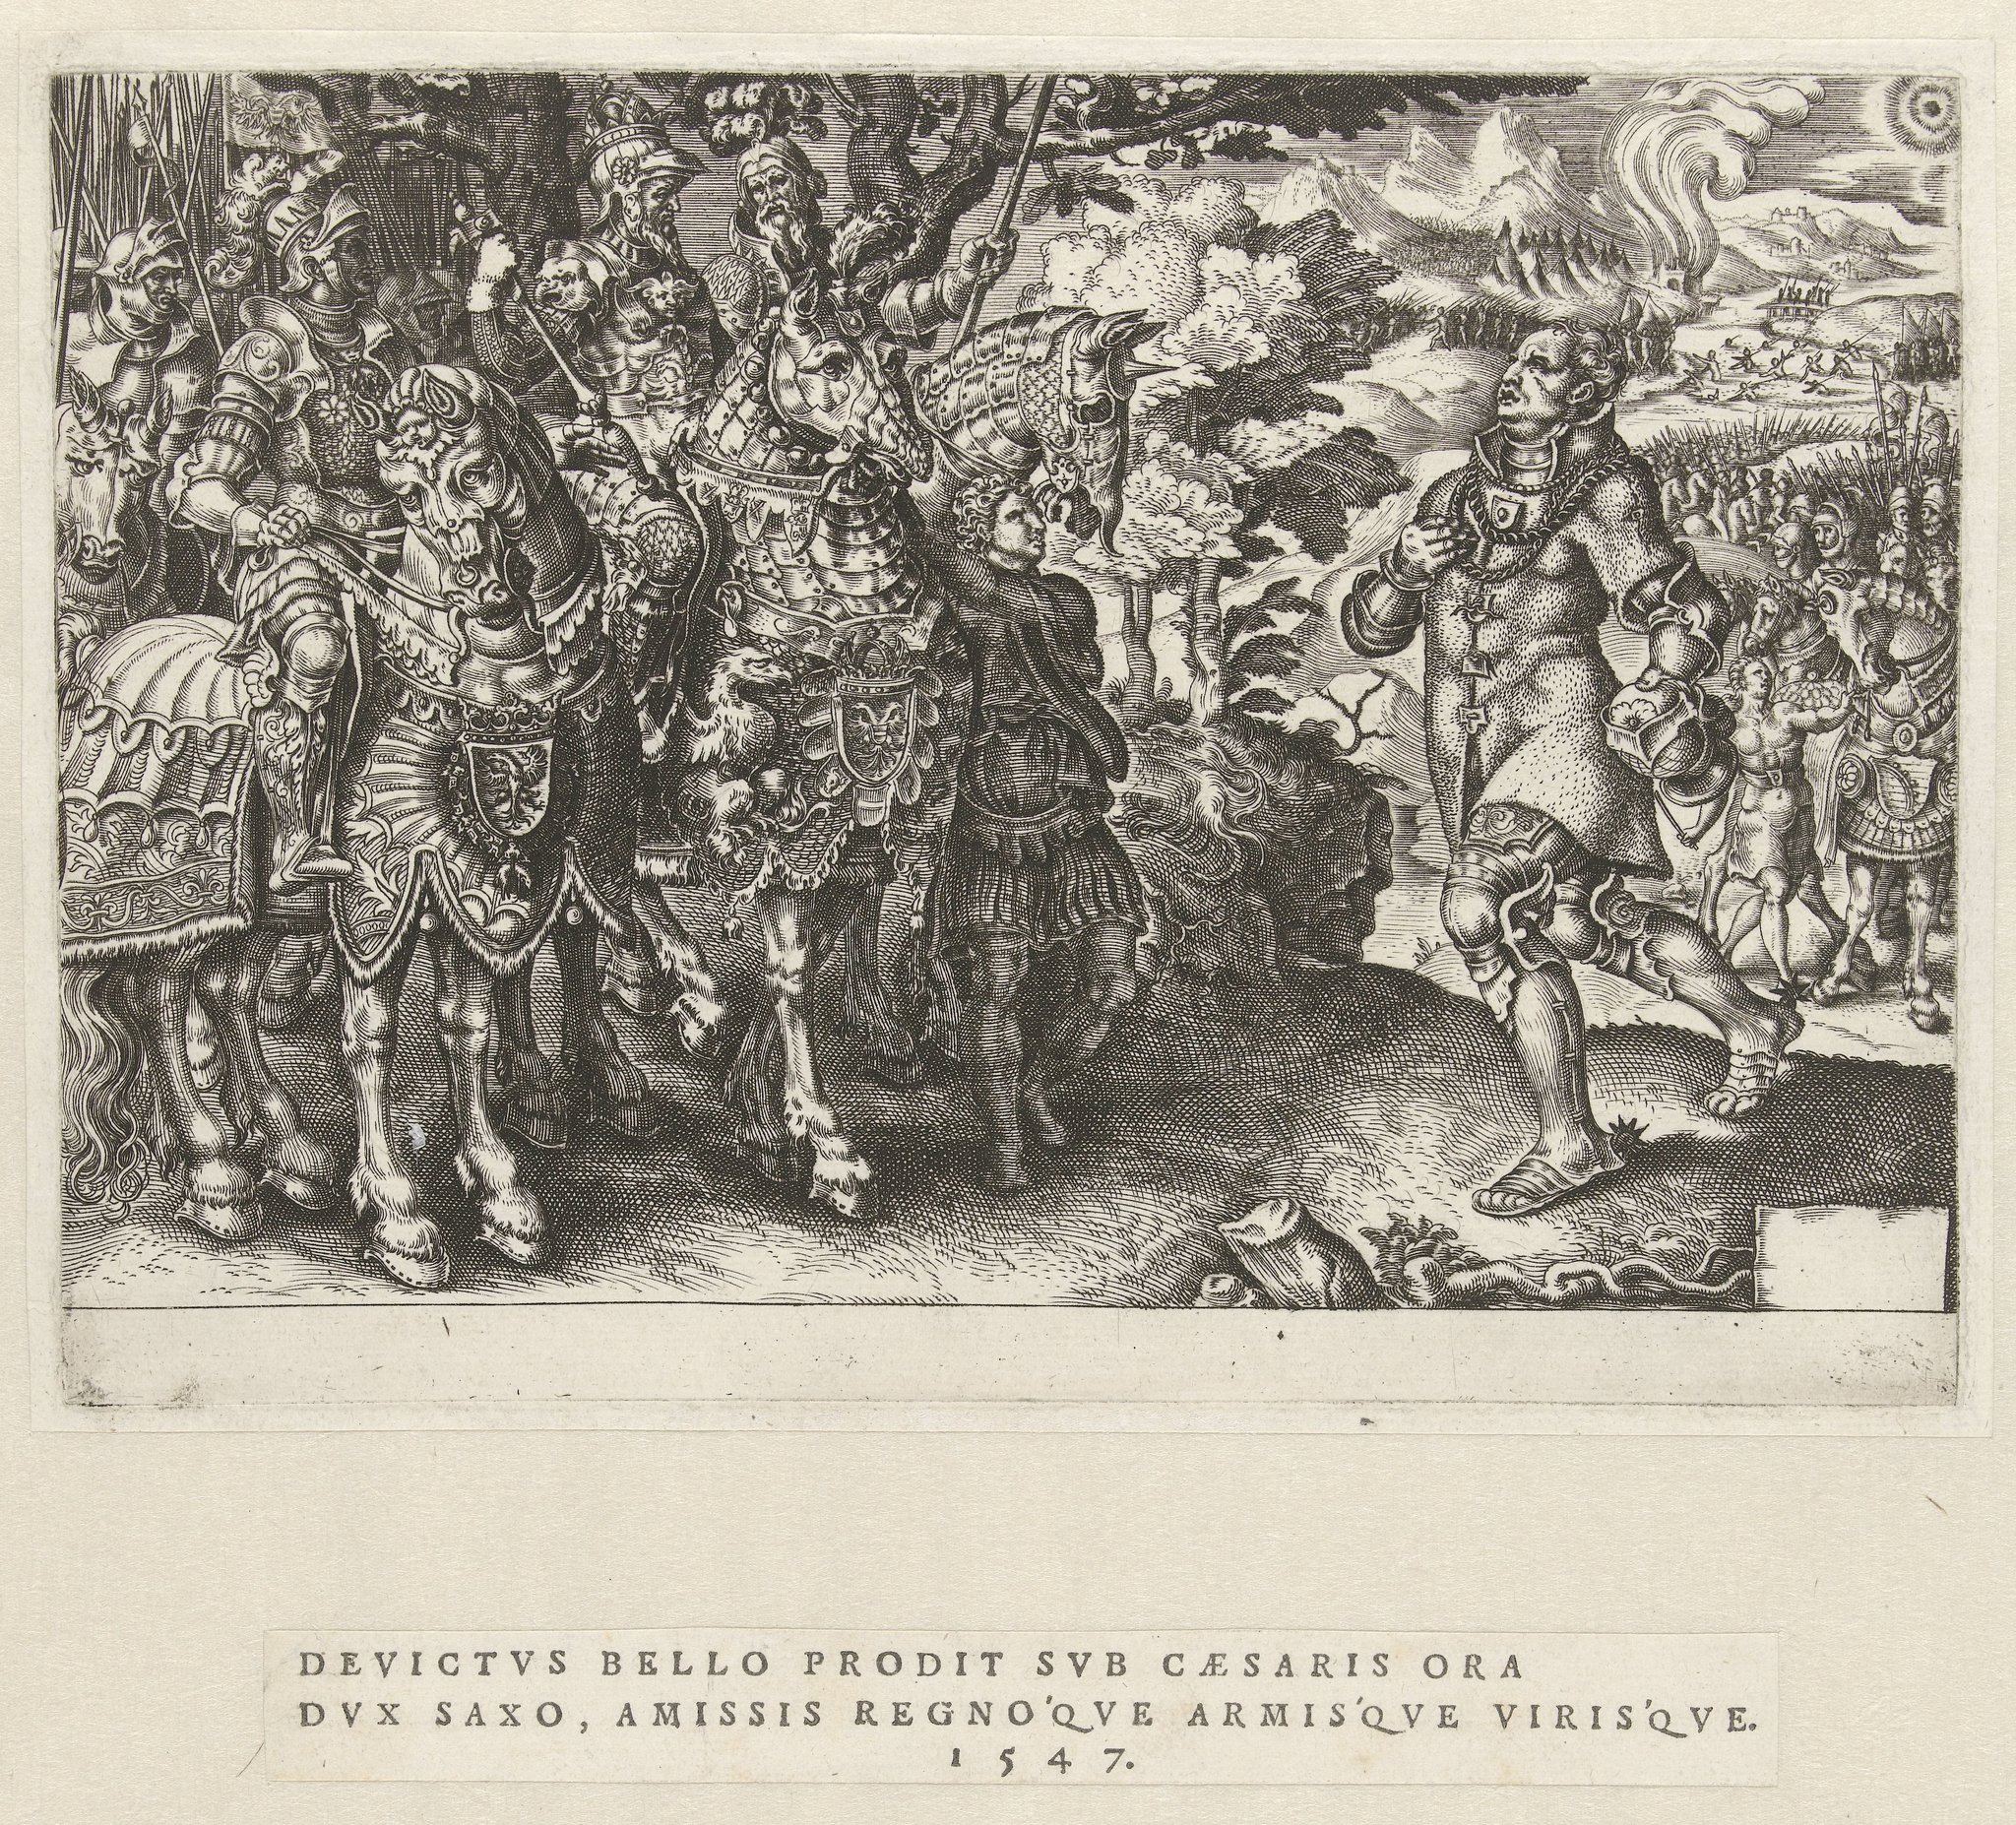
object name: history print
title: Overgave van de hertog van Saksen op het slagveld van Mühlberg, 1547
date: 1556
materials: paper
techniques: engraving, etching, letterpress printing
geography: haarlem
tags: fernando álvarez de toledo (3rd duke of alba), charles v (holy roman emperor and king of spain), vienna, ferdinand i van habsburg (duits keizer), battle of mühlberg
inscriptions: collector's mark: Lugt 2228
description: Na de slag bij Mühlberg (1547) geeft Johan Frederik, keurvorst van Saksen, zich over aan Karel V. Naast Karel V de hertog van Alva en koning Ferdinand van Oostenrijk. In de achtergrond de veldslag. De prent maakt deel uit van een twaalfdelige serie over de overwinningen van Karel V. Hij heeft een aparte tekststrook met een Latijnse tekst.